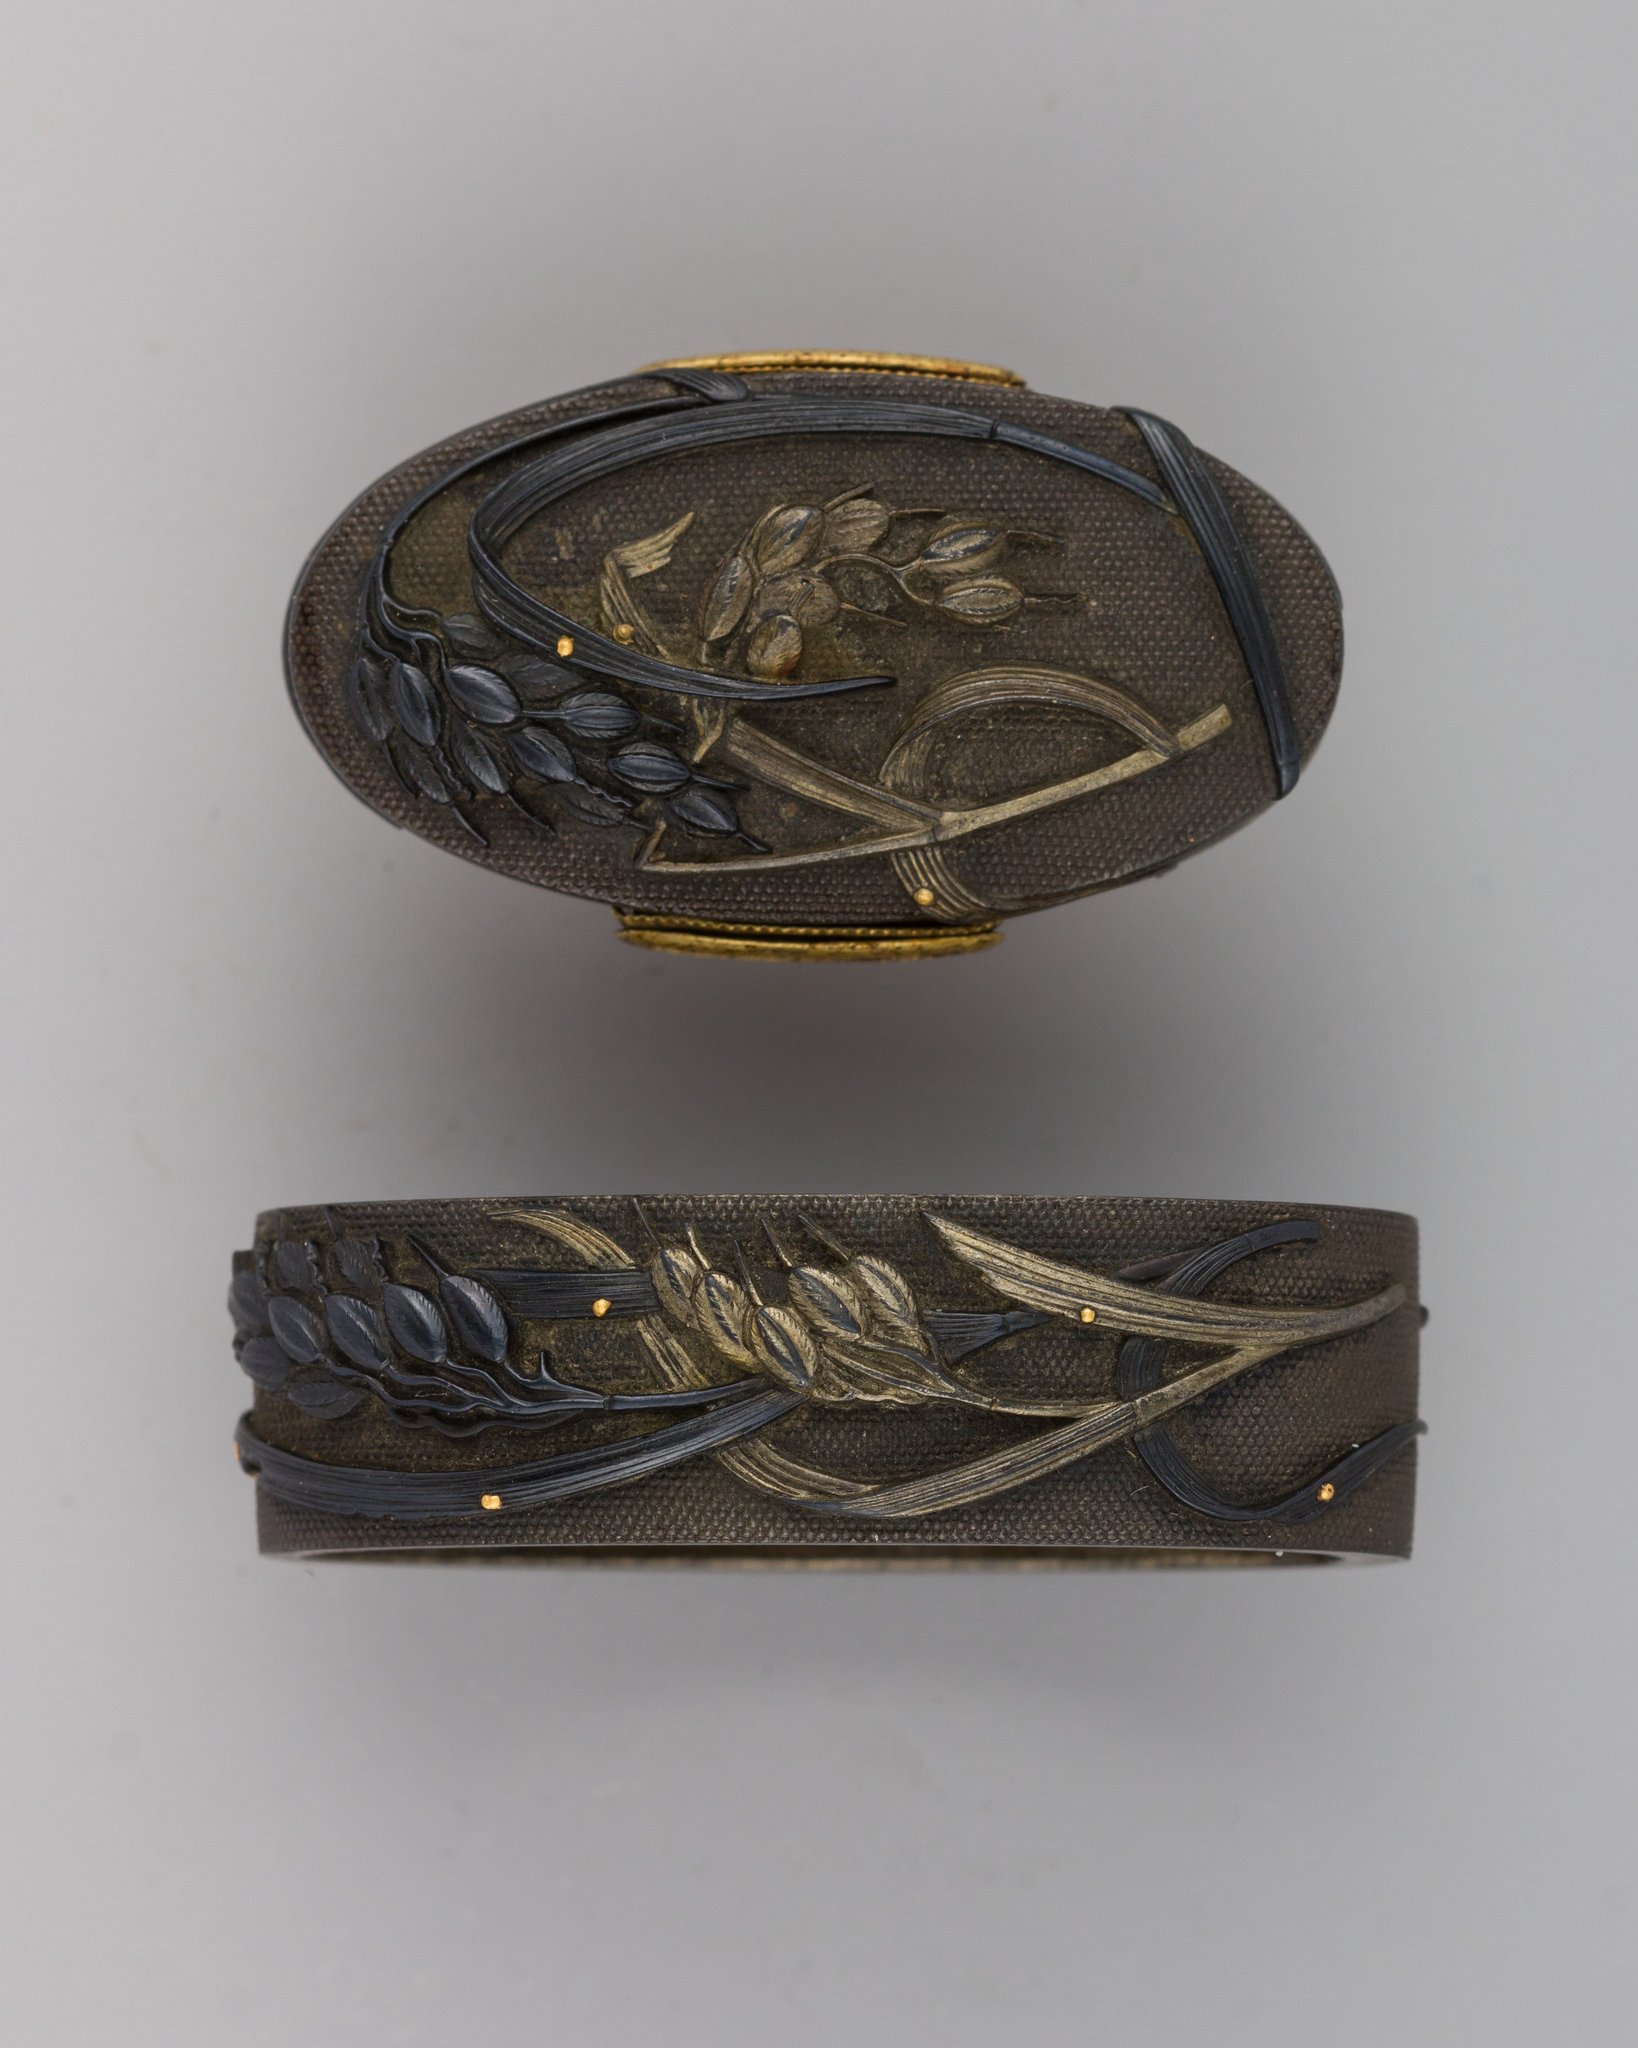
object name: sword hilt collar and pommel fuchigashira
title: Sword-Hilt Collar and Pommel (Fuchigashira)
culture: japanese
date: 1615-1868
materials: gold alloy, silver alloy, silver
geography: japan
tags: plants